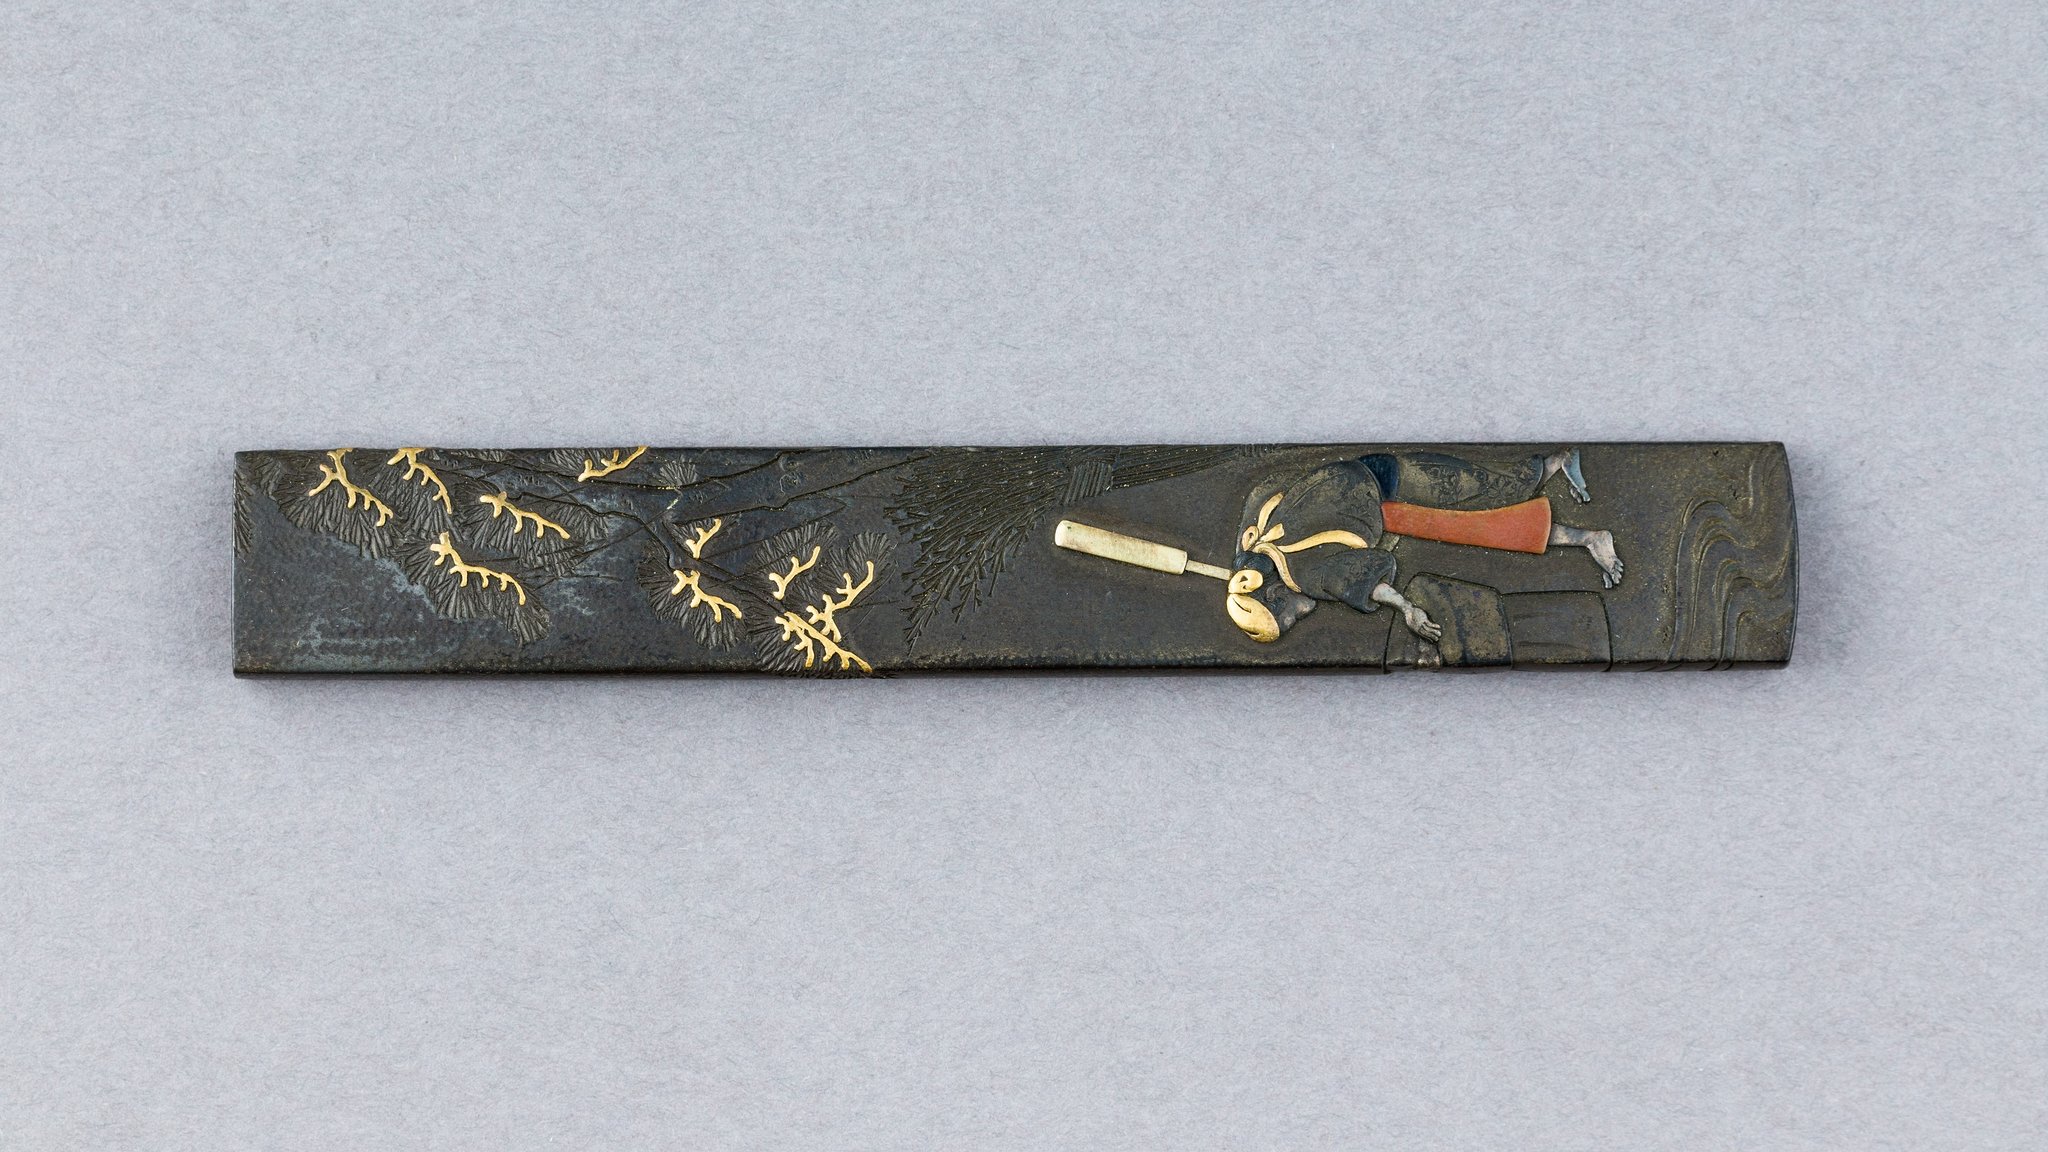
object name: knife handle kozuka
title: Knife Handle (Kozuka)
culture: japanese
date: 1615-1868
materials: gold alloy, silver alloy, gold, silver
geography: japan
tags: men,trees